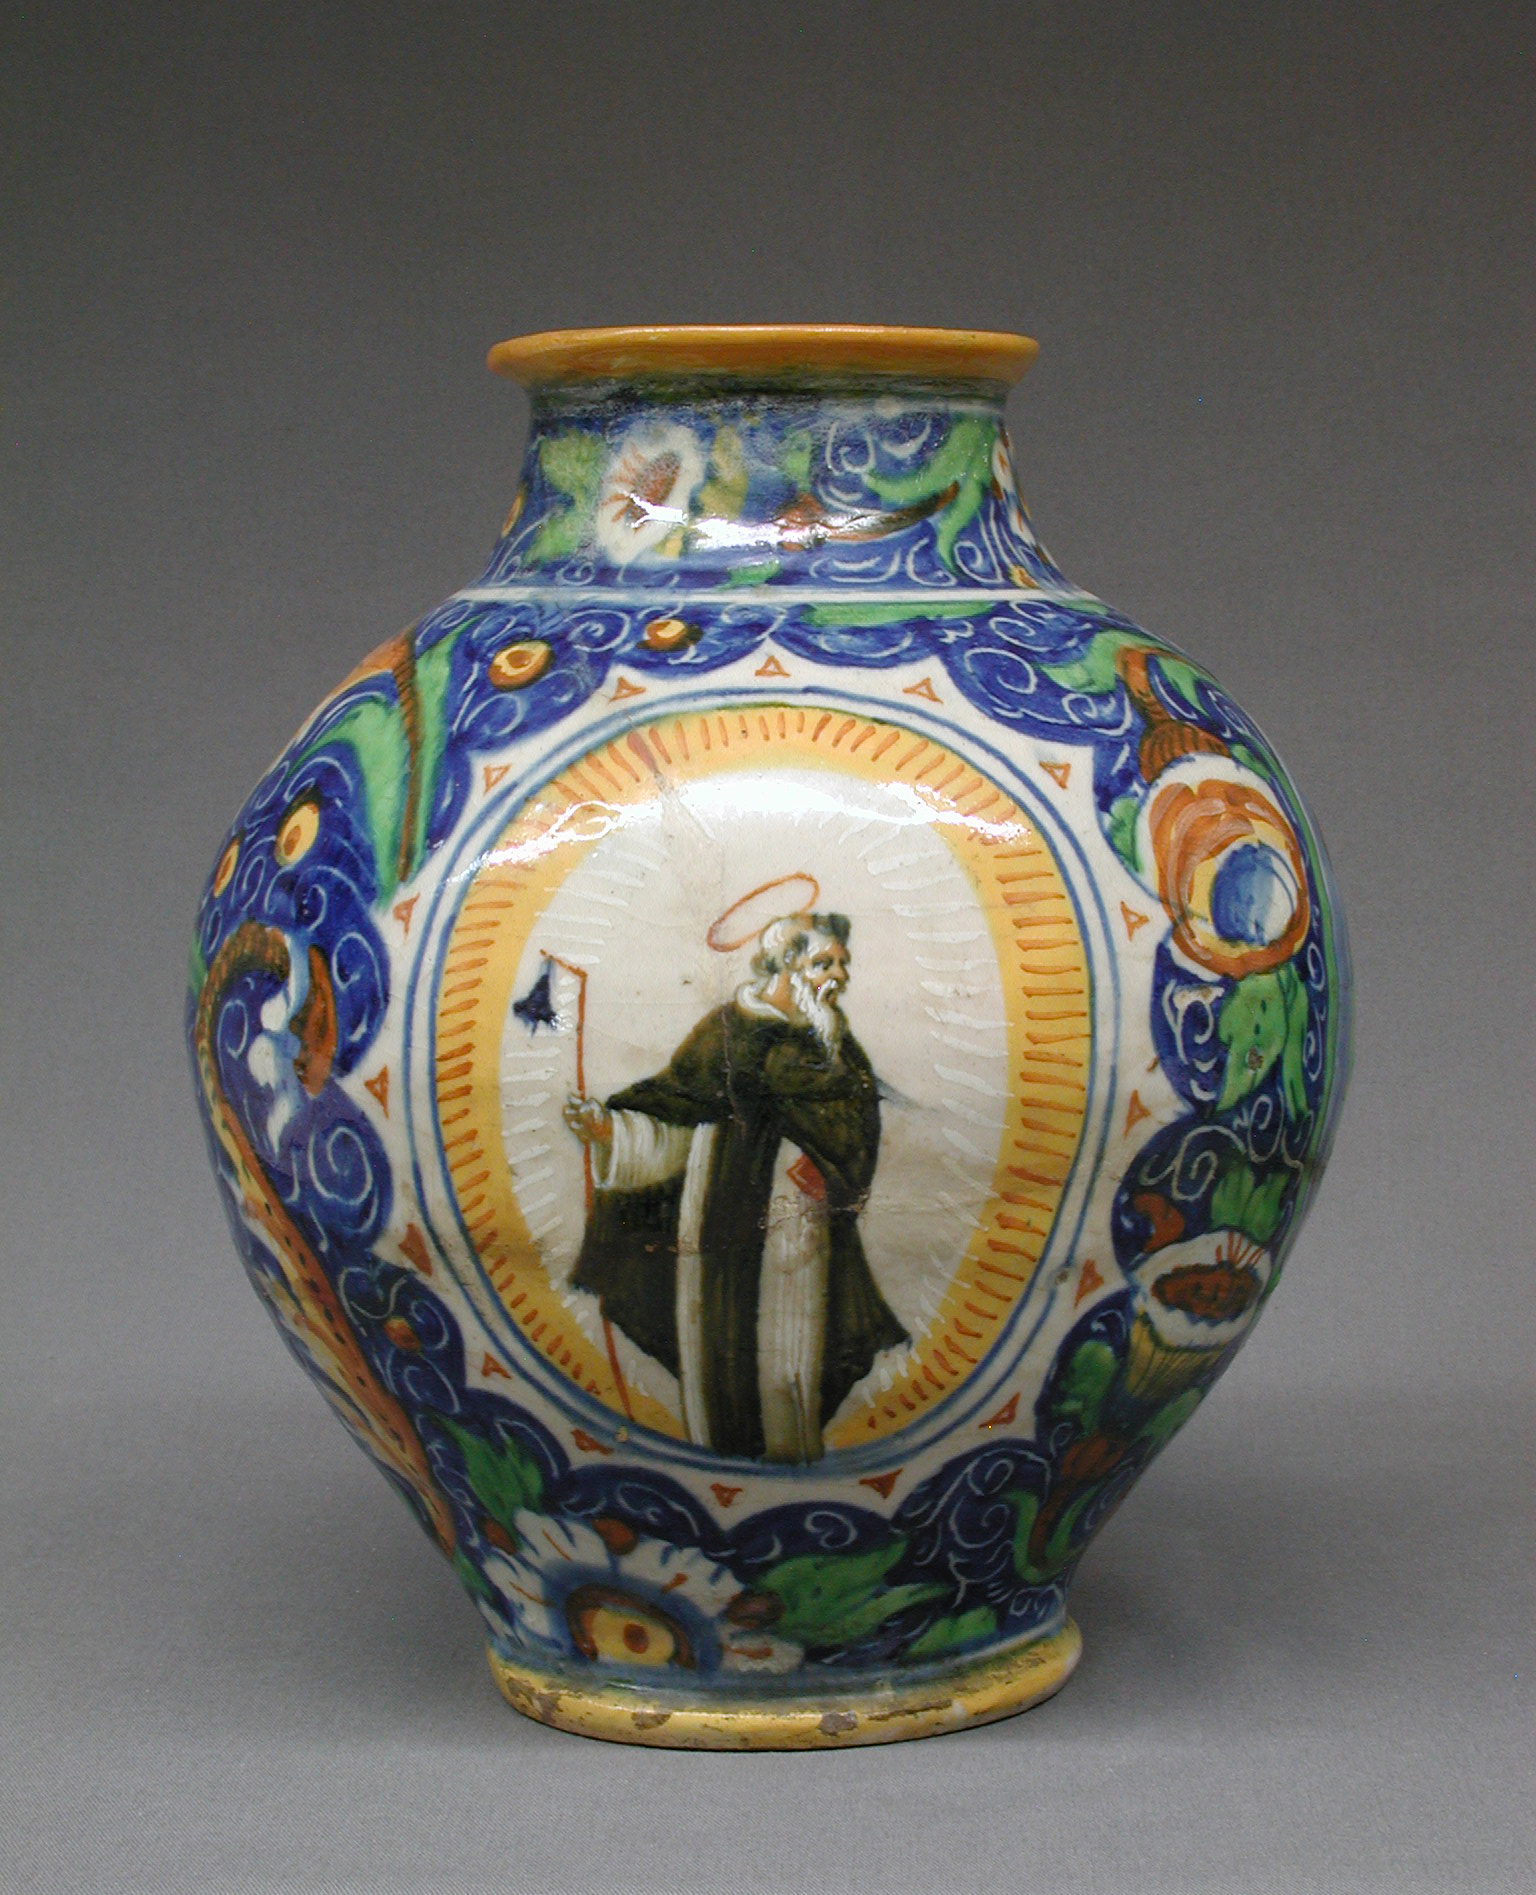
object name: globular vase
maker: domenico veneziano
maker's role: maker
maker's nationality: italian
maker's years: 1438-1461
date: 1567-1600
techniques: maiolica, glazing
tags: men,flowers